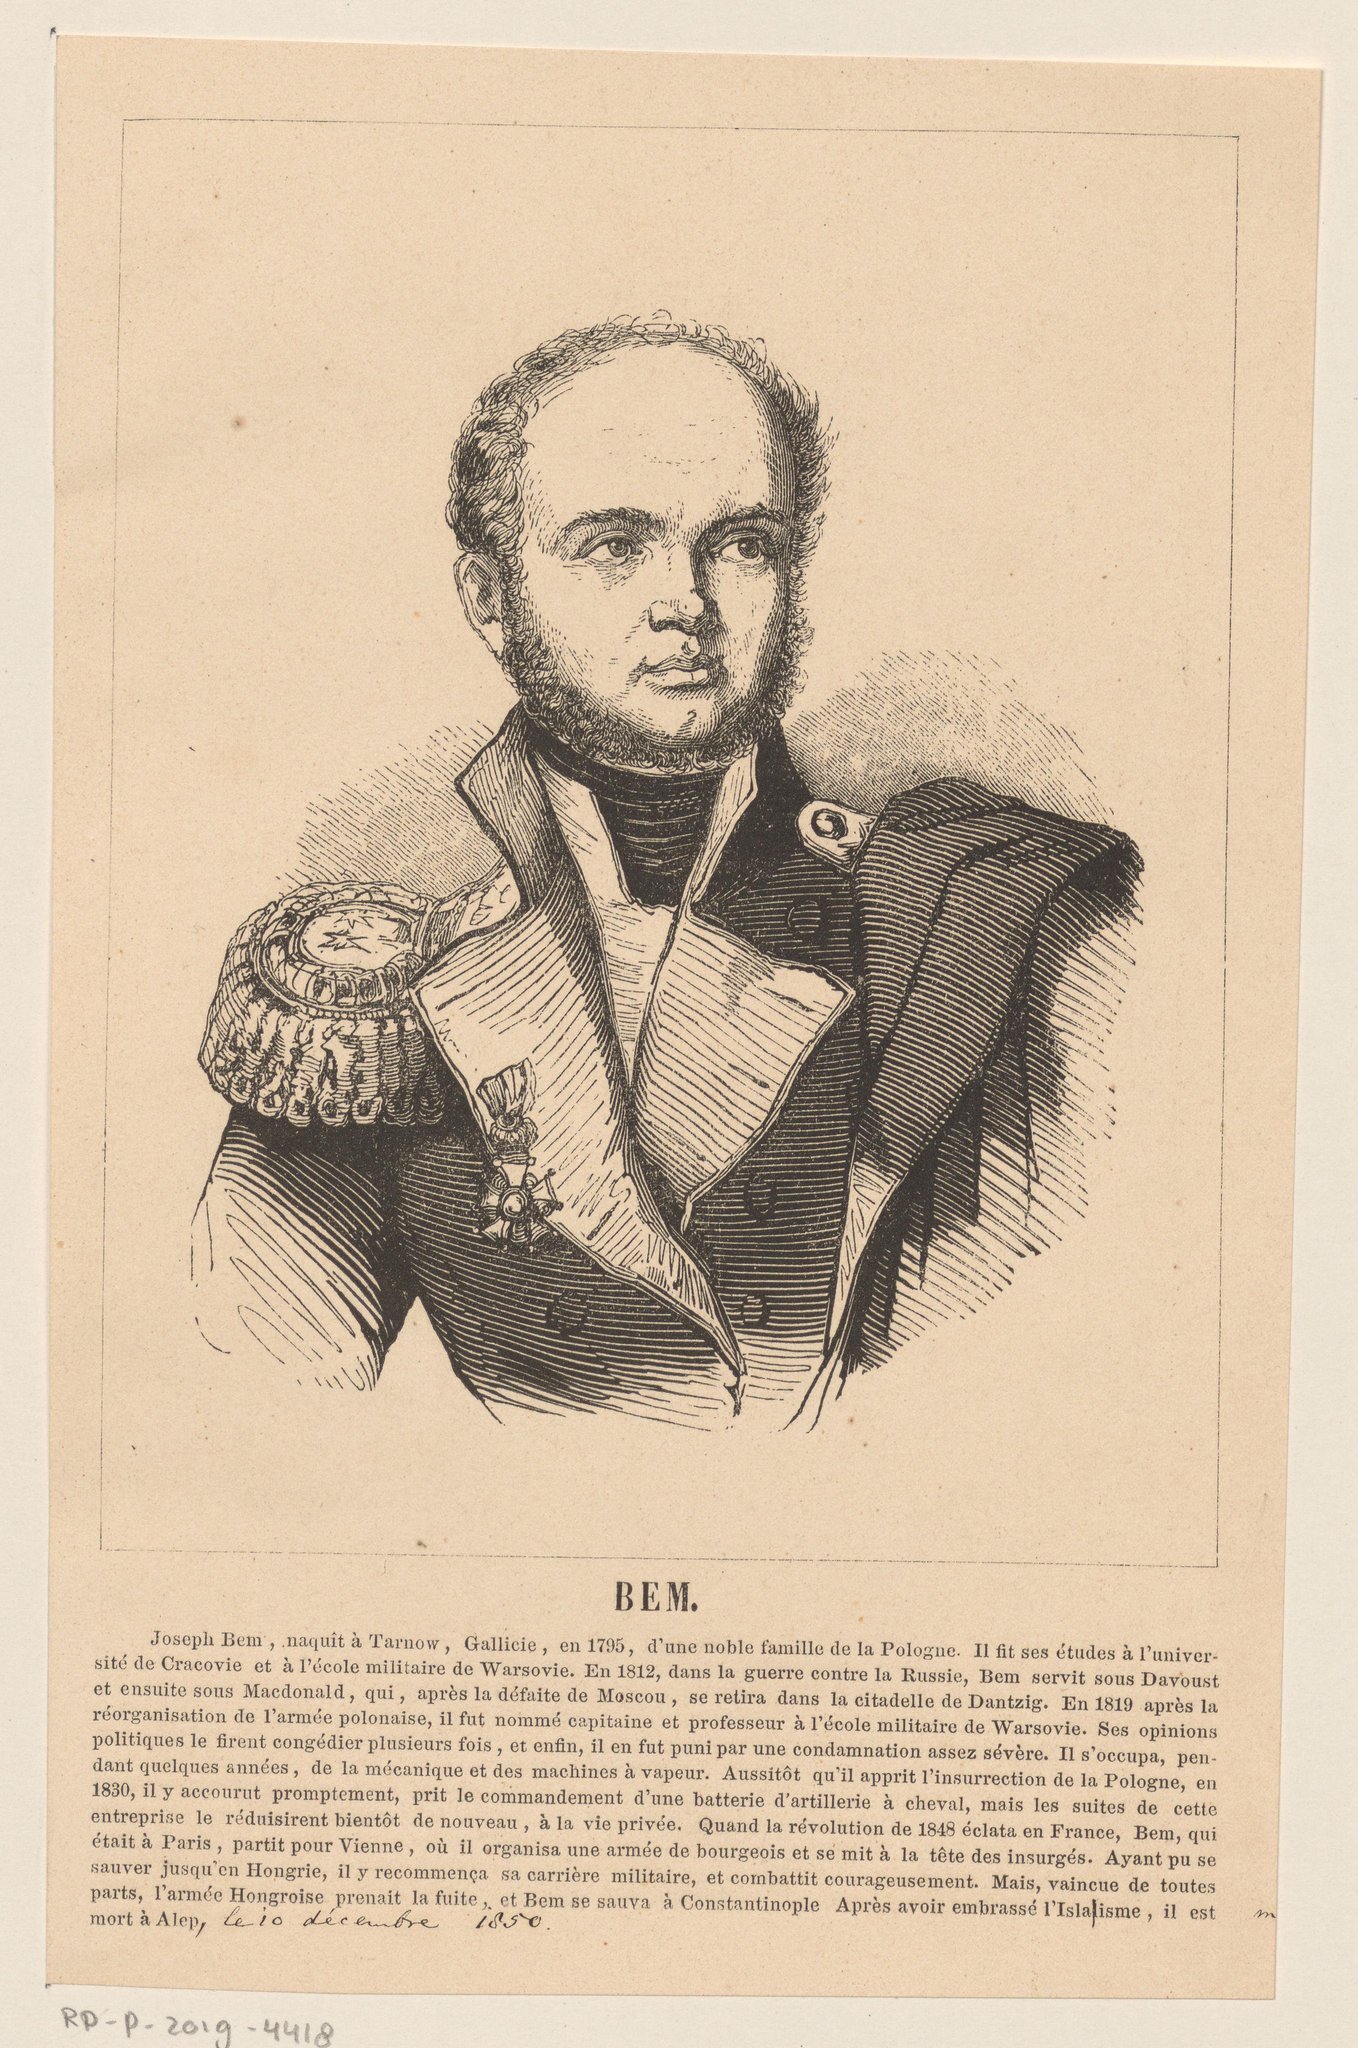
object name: book illustration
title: Portret van Józef Bem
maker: Anonymous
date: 1852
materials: paper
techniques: letterpress printing, engraving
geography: stuttgart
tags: engineer, historical persons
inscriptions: inscription: ‘le 10 décembre 1850.’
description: Prent uit: Galerie des célébrités contemporaines de l'Europe, contenant le portrait des principaux personnages illustres (...). Stuttgart: Imprimerie Royale, 1852.